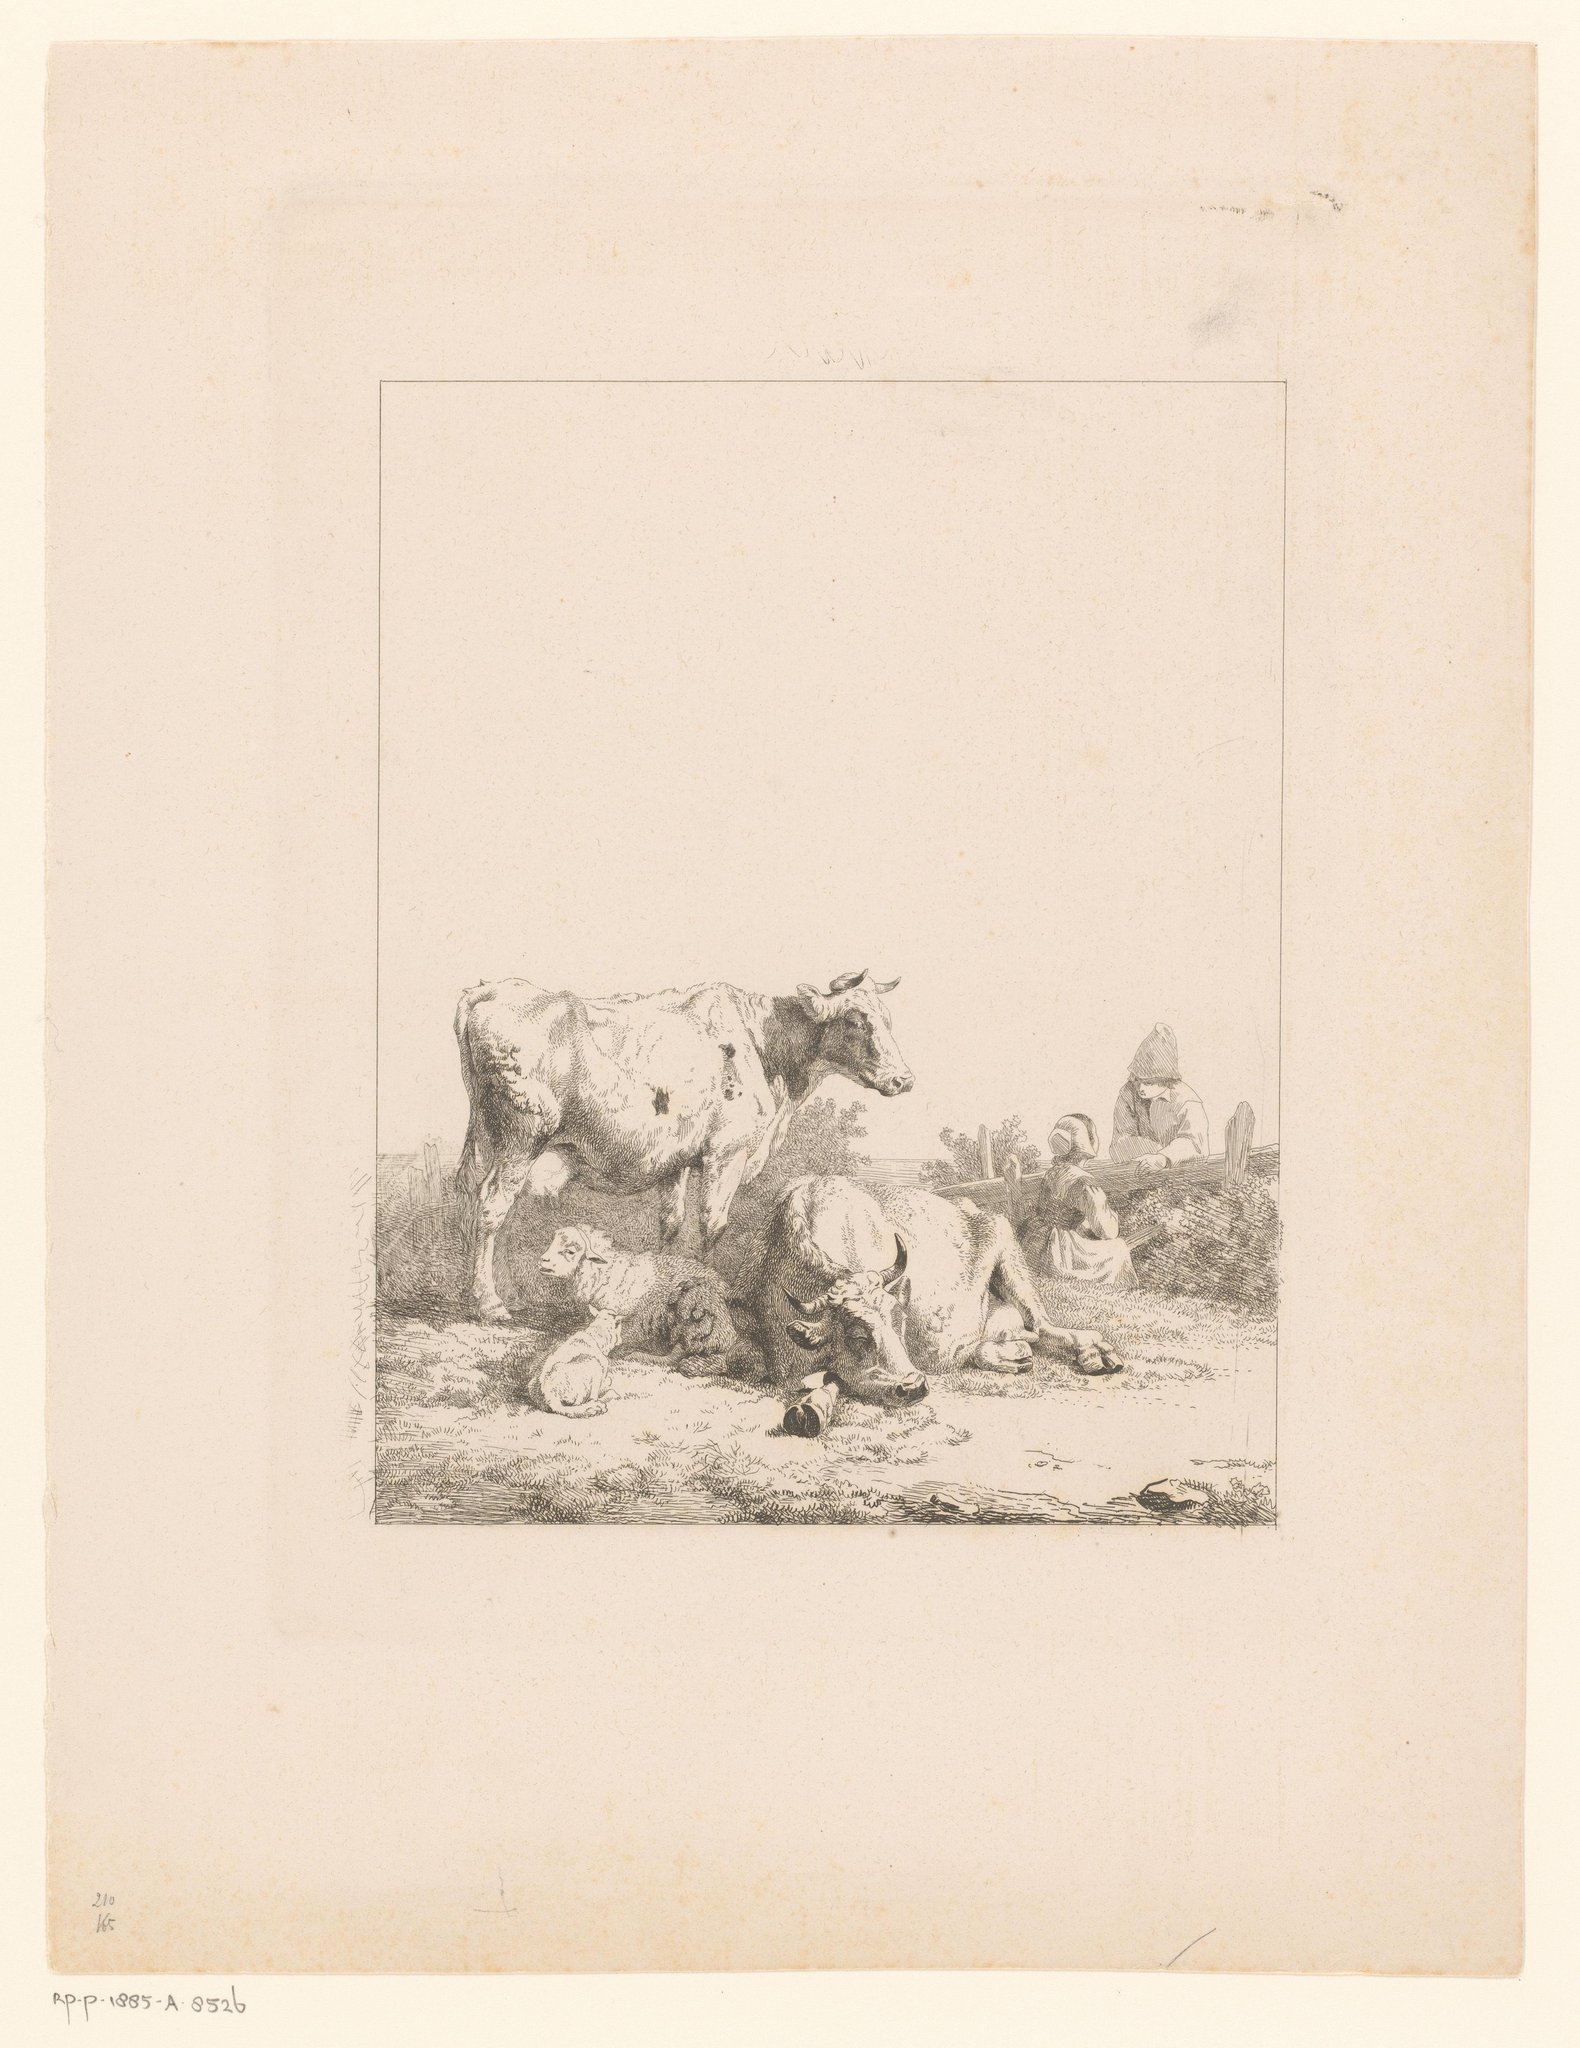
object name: print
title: Schaap, lam en twee koeien in een wei met boer en boerin bij het hek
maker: edmond tschaggeny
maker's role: print maker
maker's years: 1818-1873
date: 1828-1873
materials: paper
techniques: etching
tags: cow, sheep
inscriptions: collector's mark: Lugt 2228